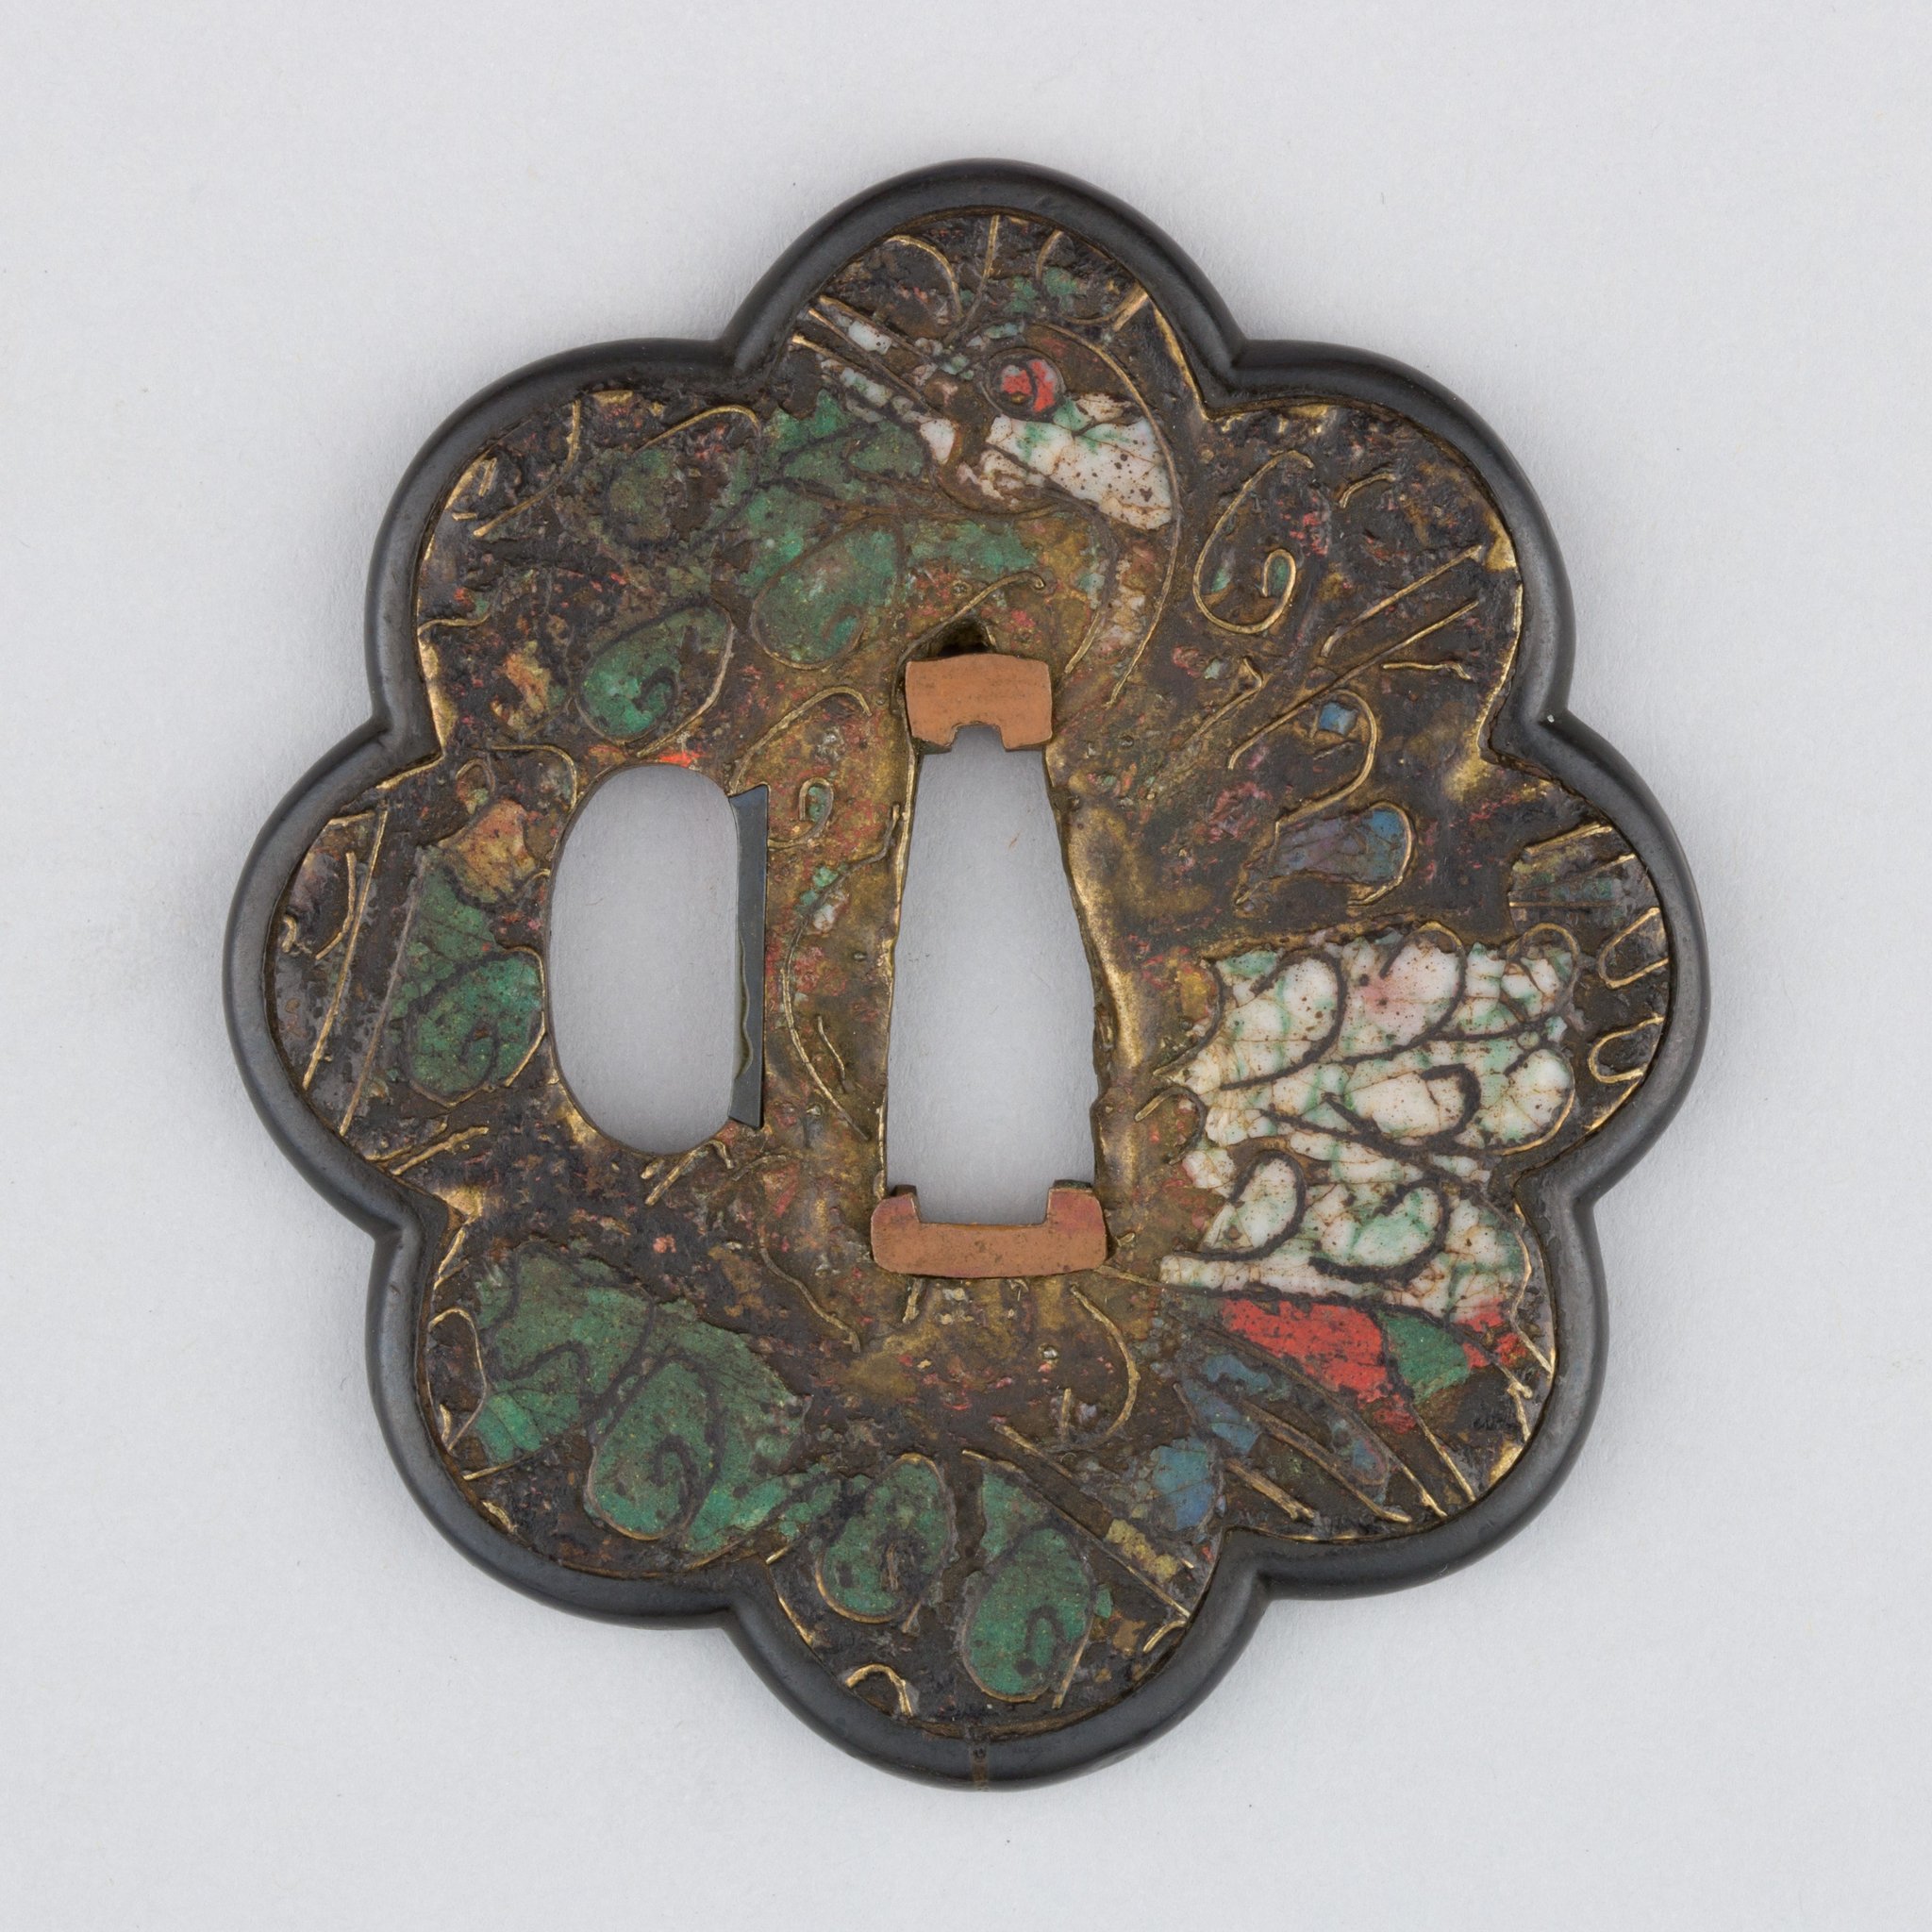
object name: sword guard tsuba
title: Sword Guard (Tsuba)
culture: japanese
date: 1601-1800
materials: copper, gold alloy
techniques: enamel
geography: japan